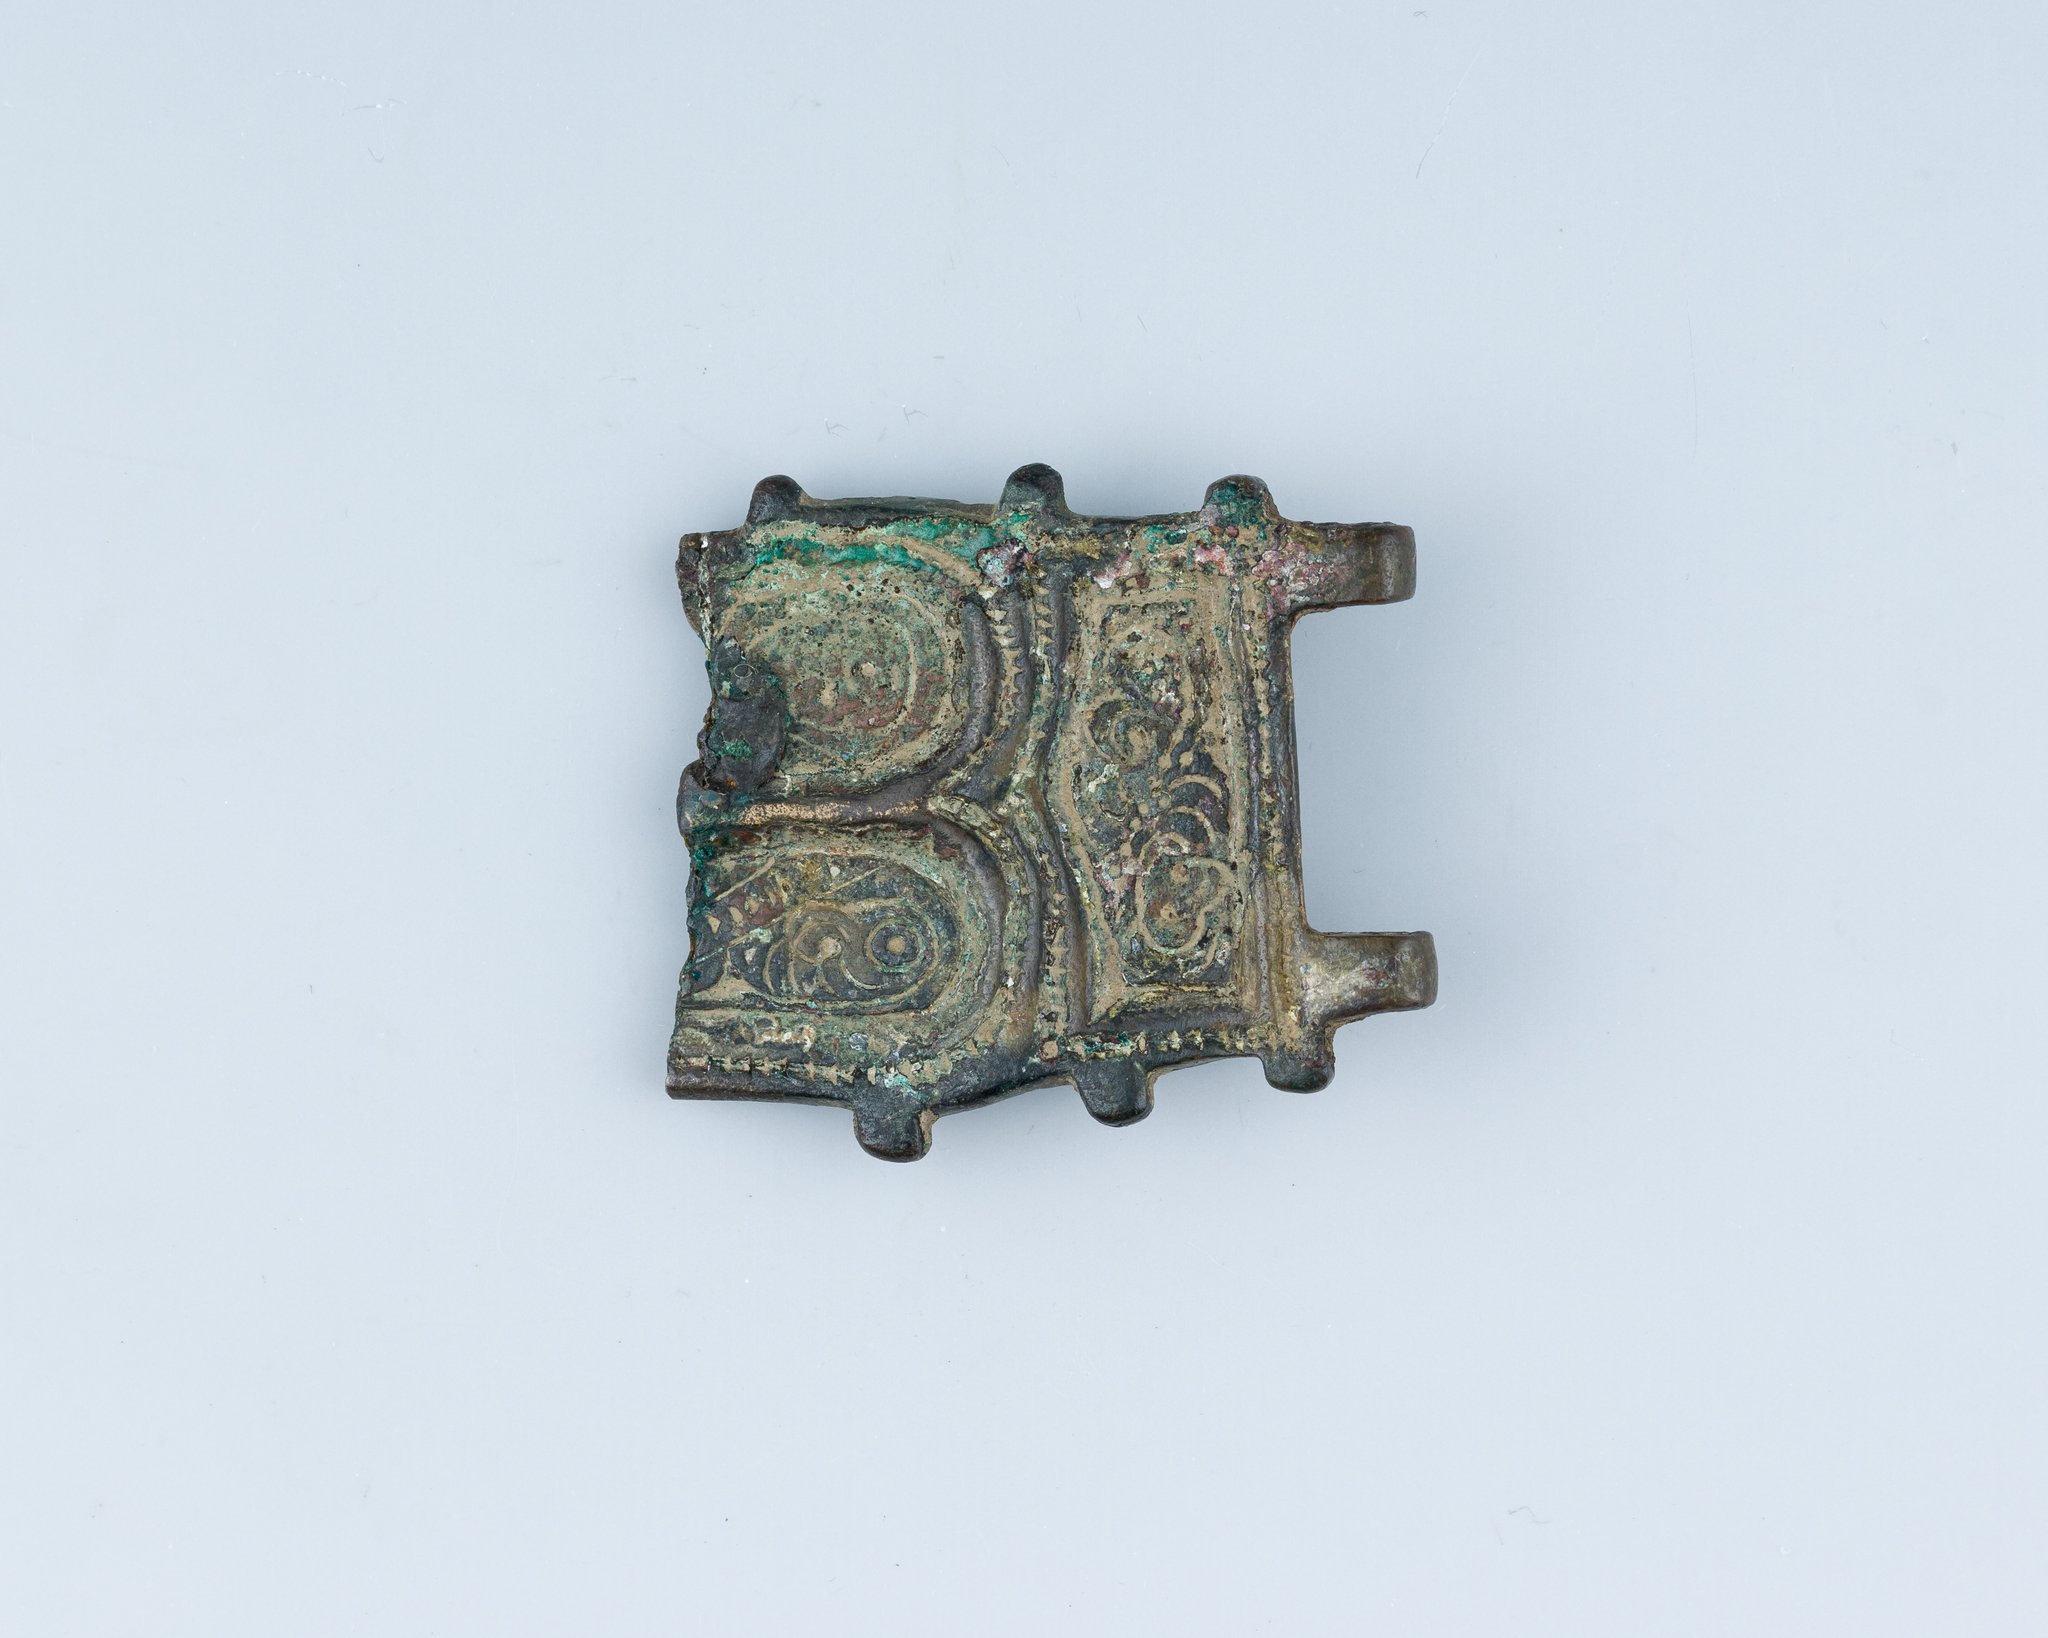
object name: buckle shank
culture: visigothic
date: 401-700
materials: bronze